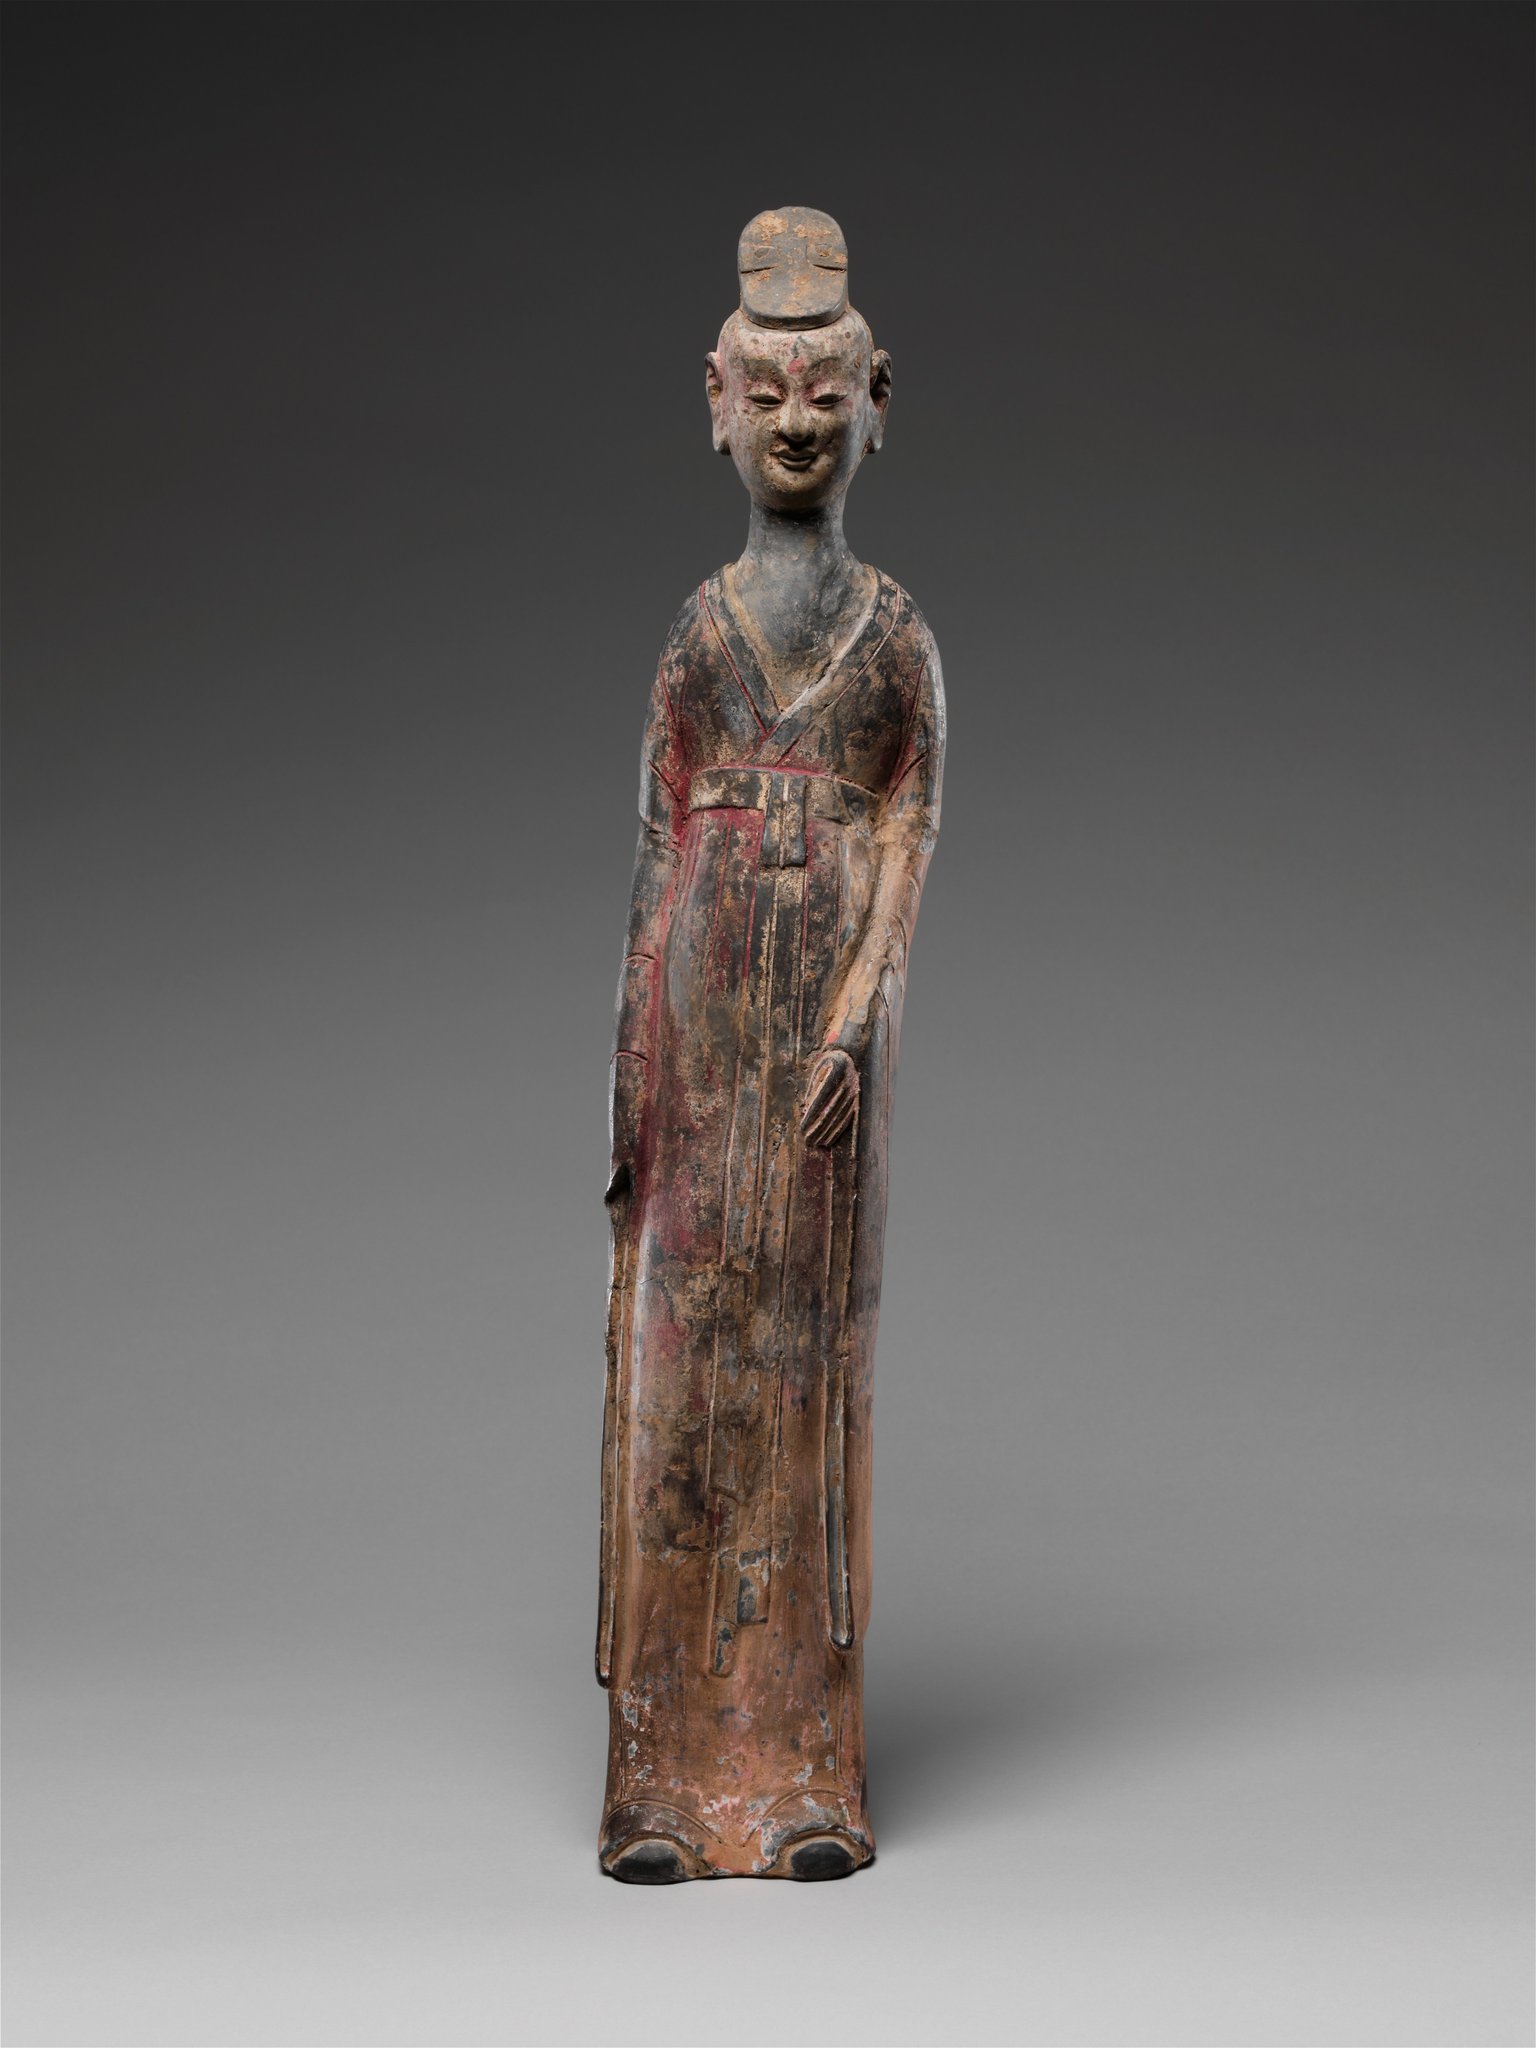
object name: figure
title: Male Palace Attendant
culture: chinese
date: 501-533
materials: earthenware, pigment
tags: men